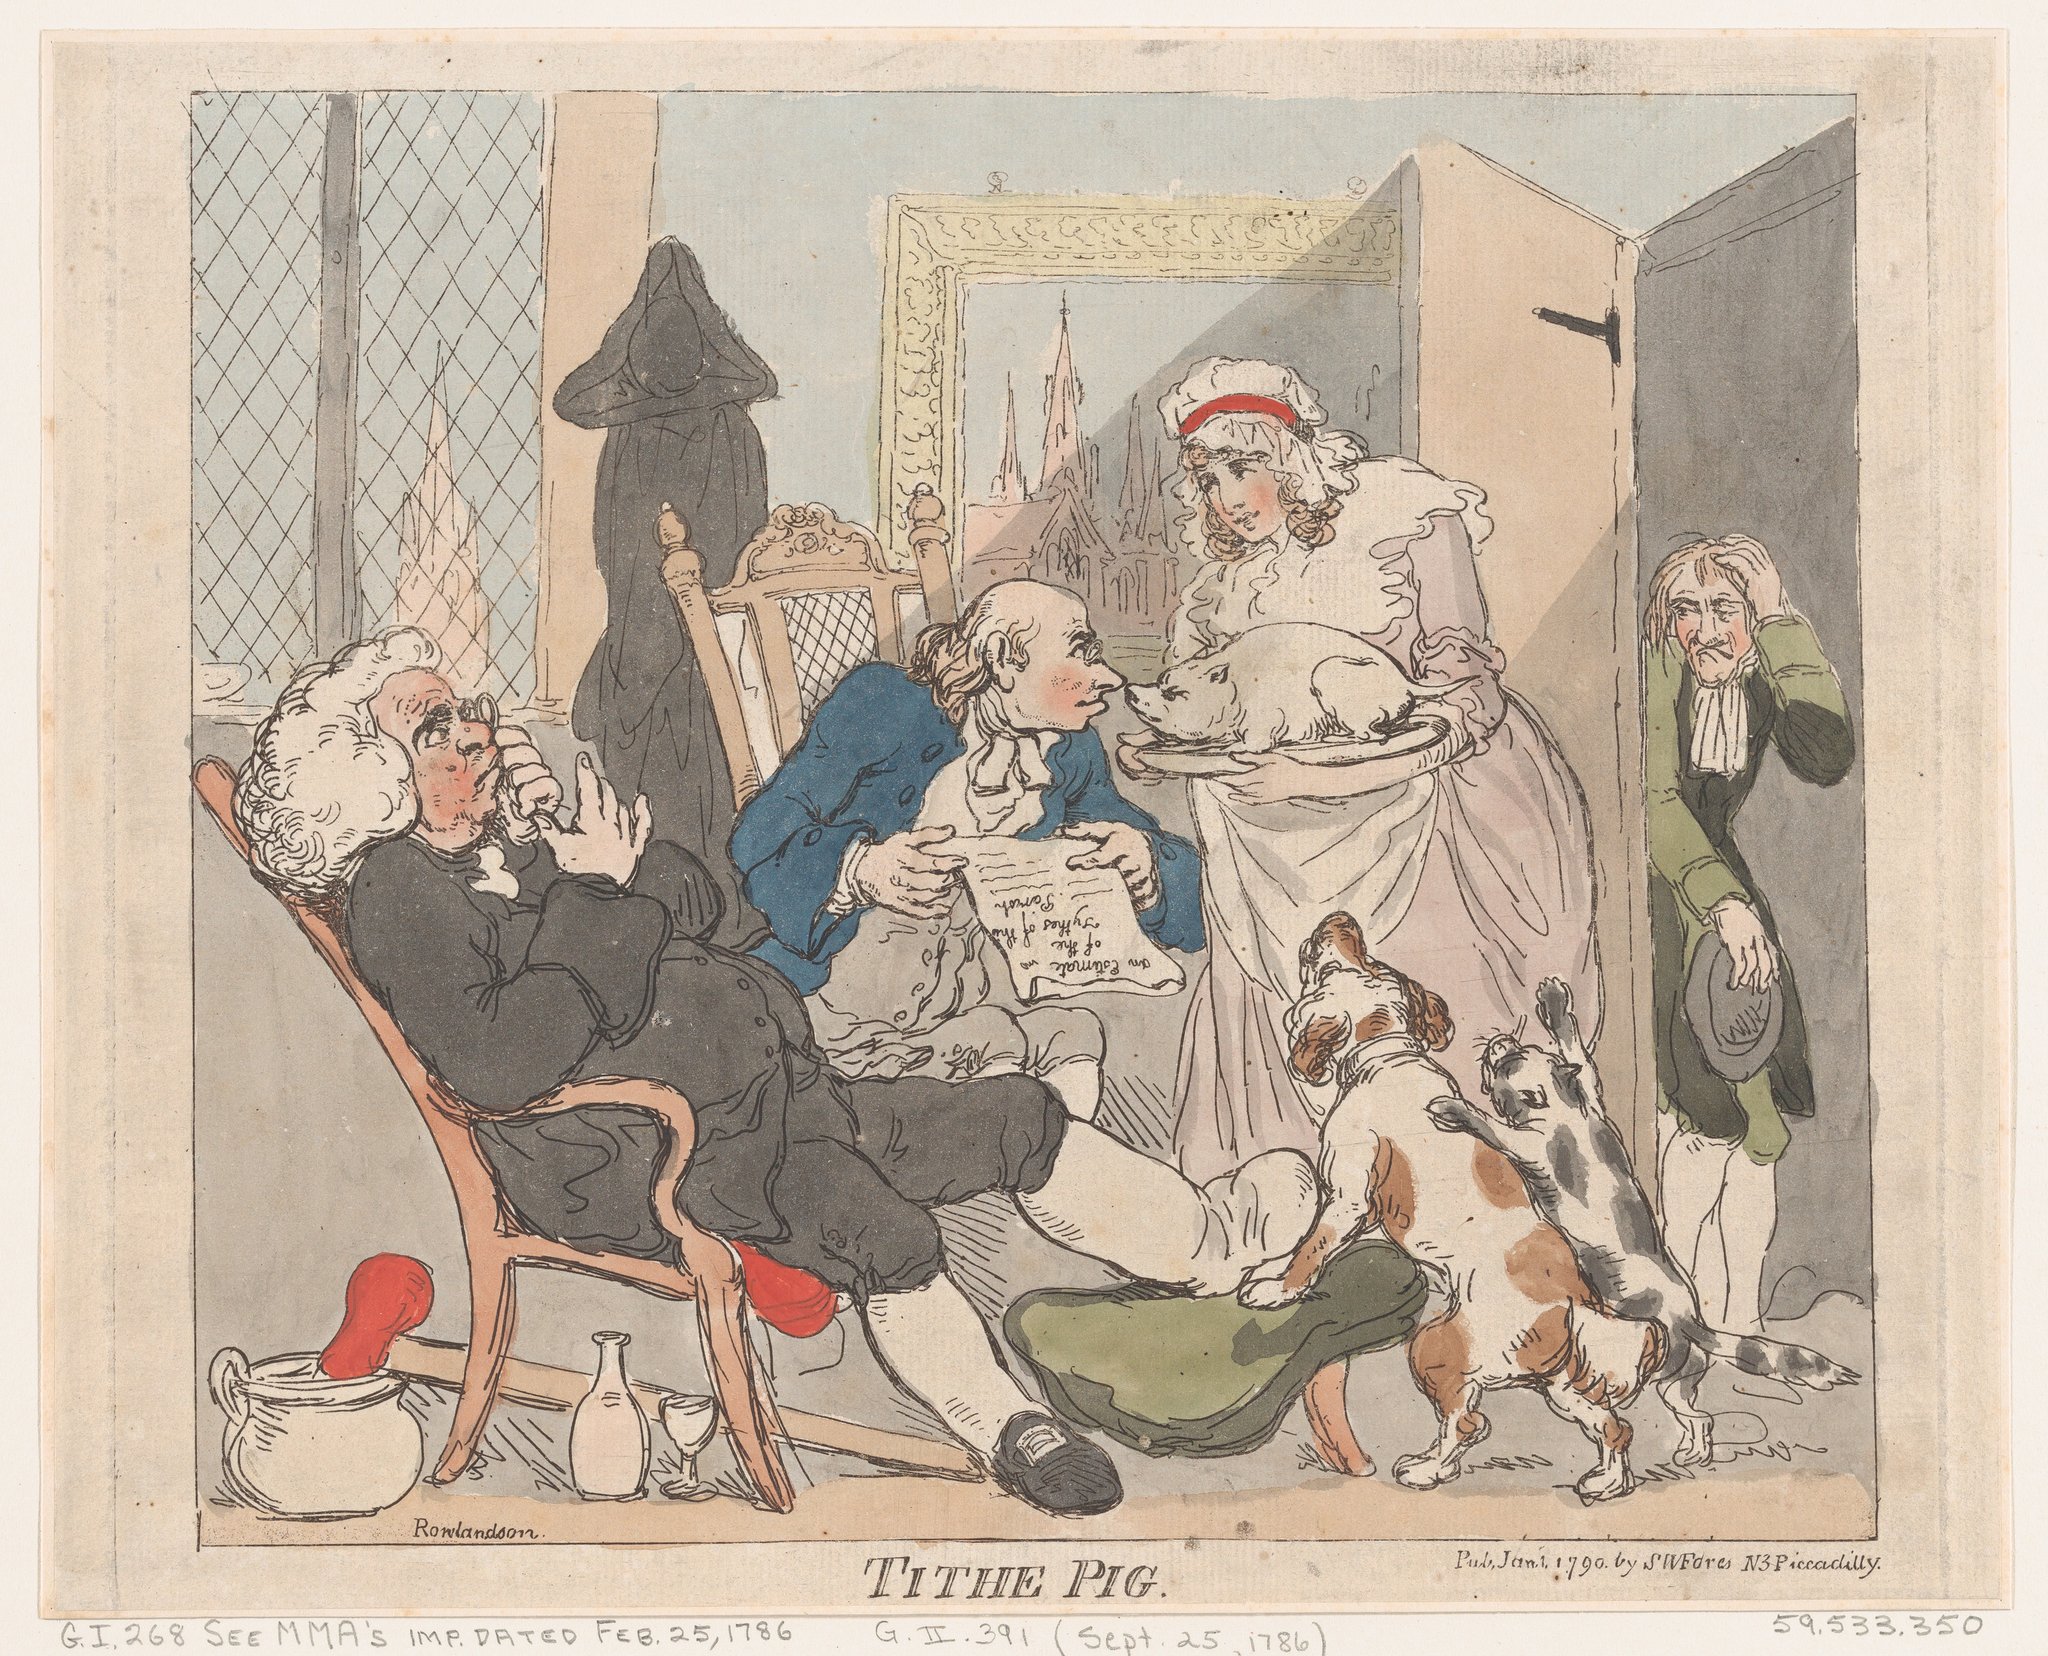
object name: print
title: Tithe Pig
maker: thomas rowlandson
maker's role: artist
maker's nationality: british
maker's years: 1757-1827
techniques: etching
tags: men,women,dogs,pigs